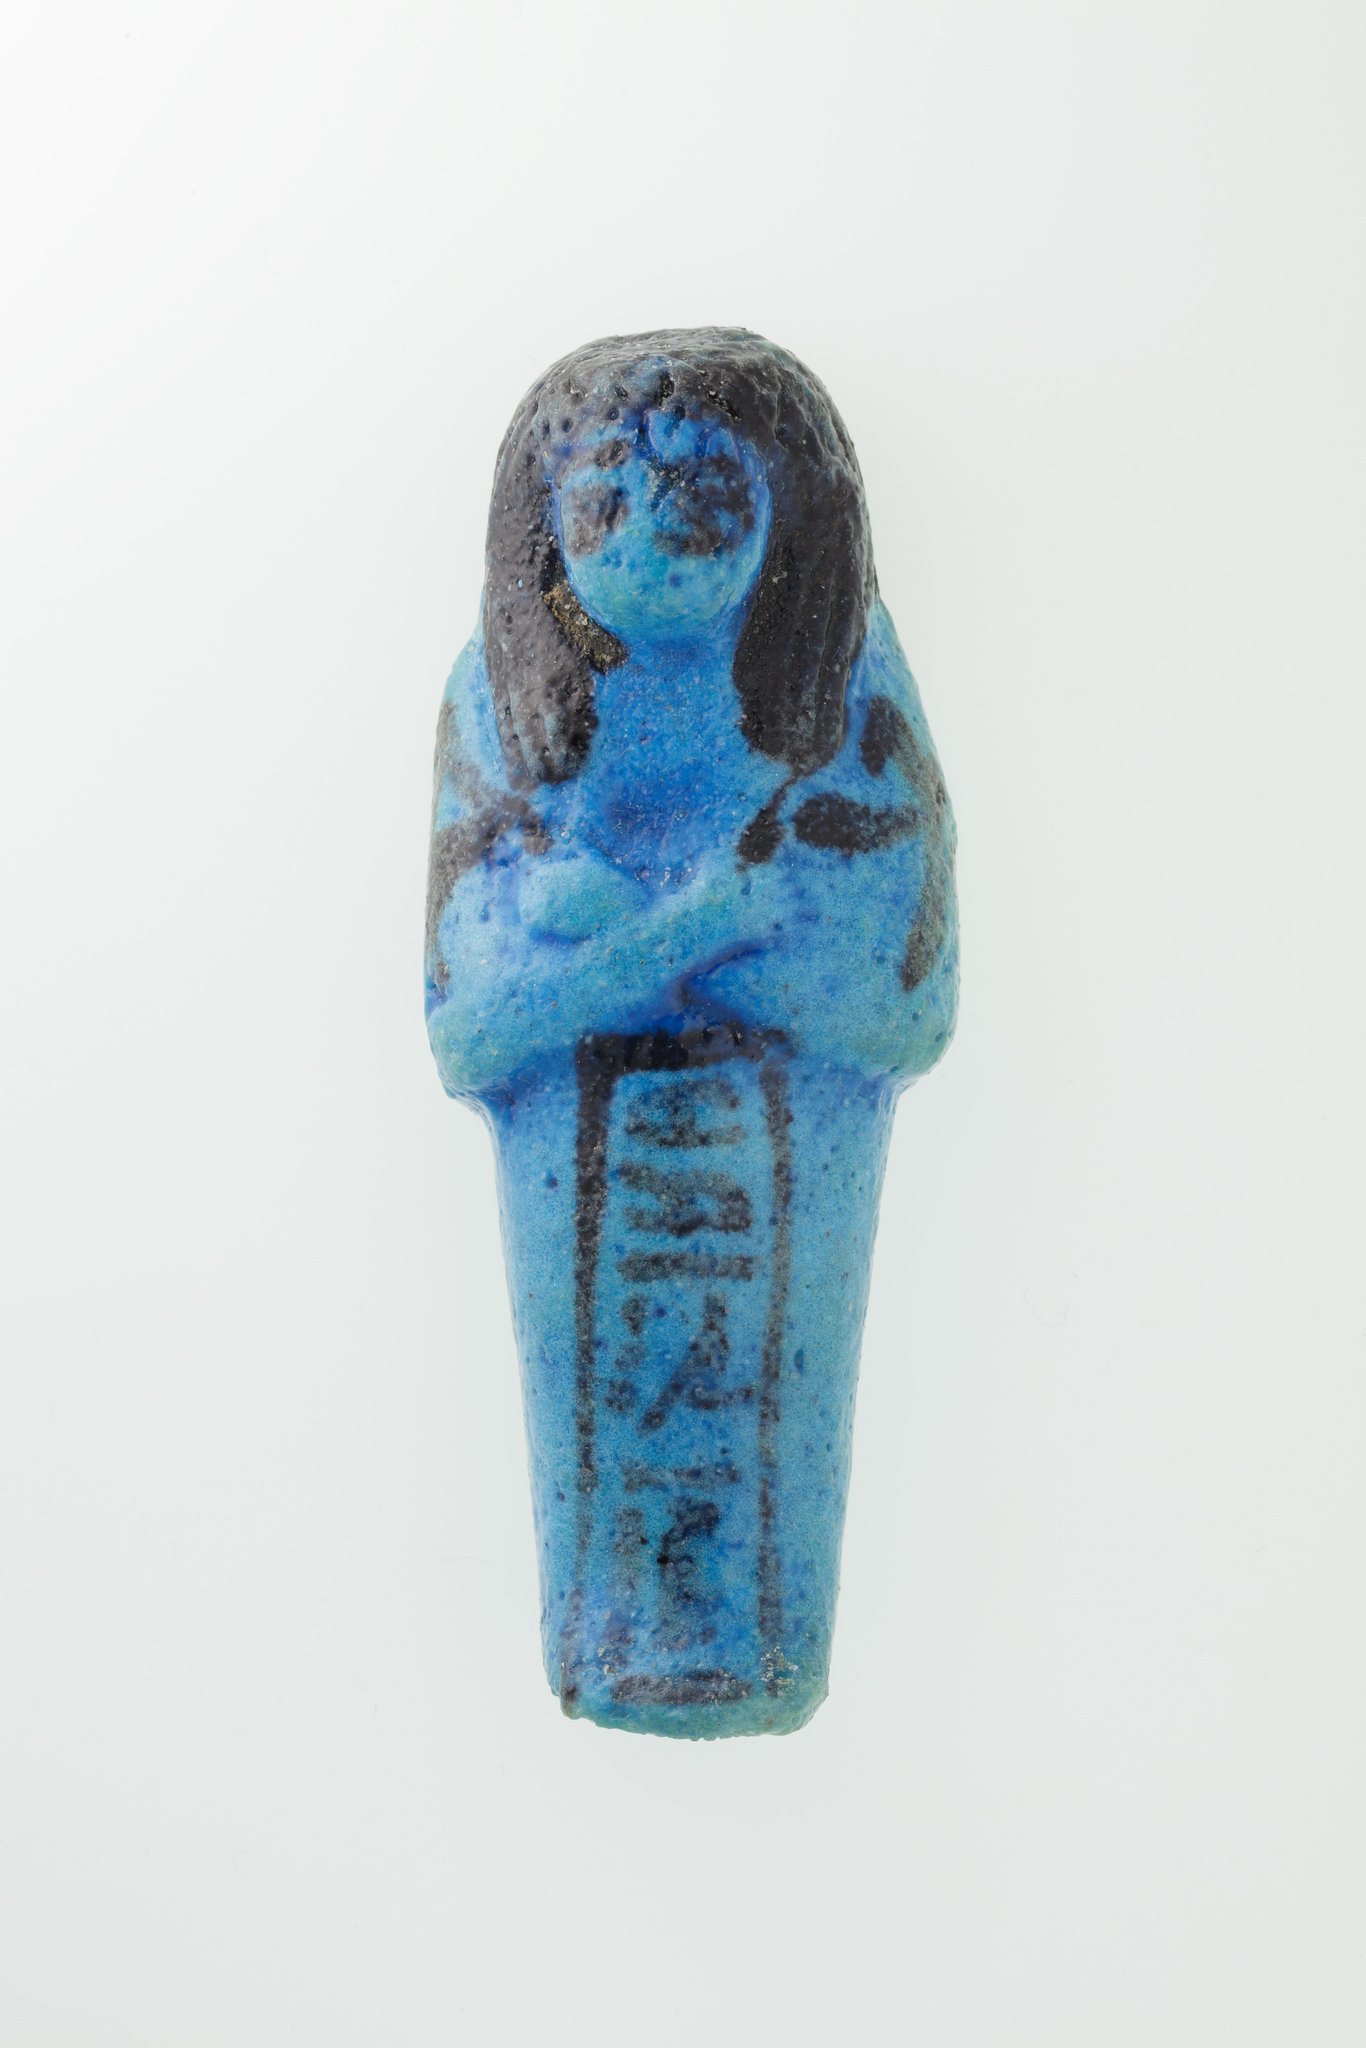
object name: shabti, worker, nauny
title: Worker Shabti of Nauny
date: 1050 BCE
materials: faience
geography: egypt